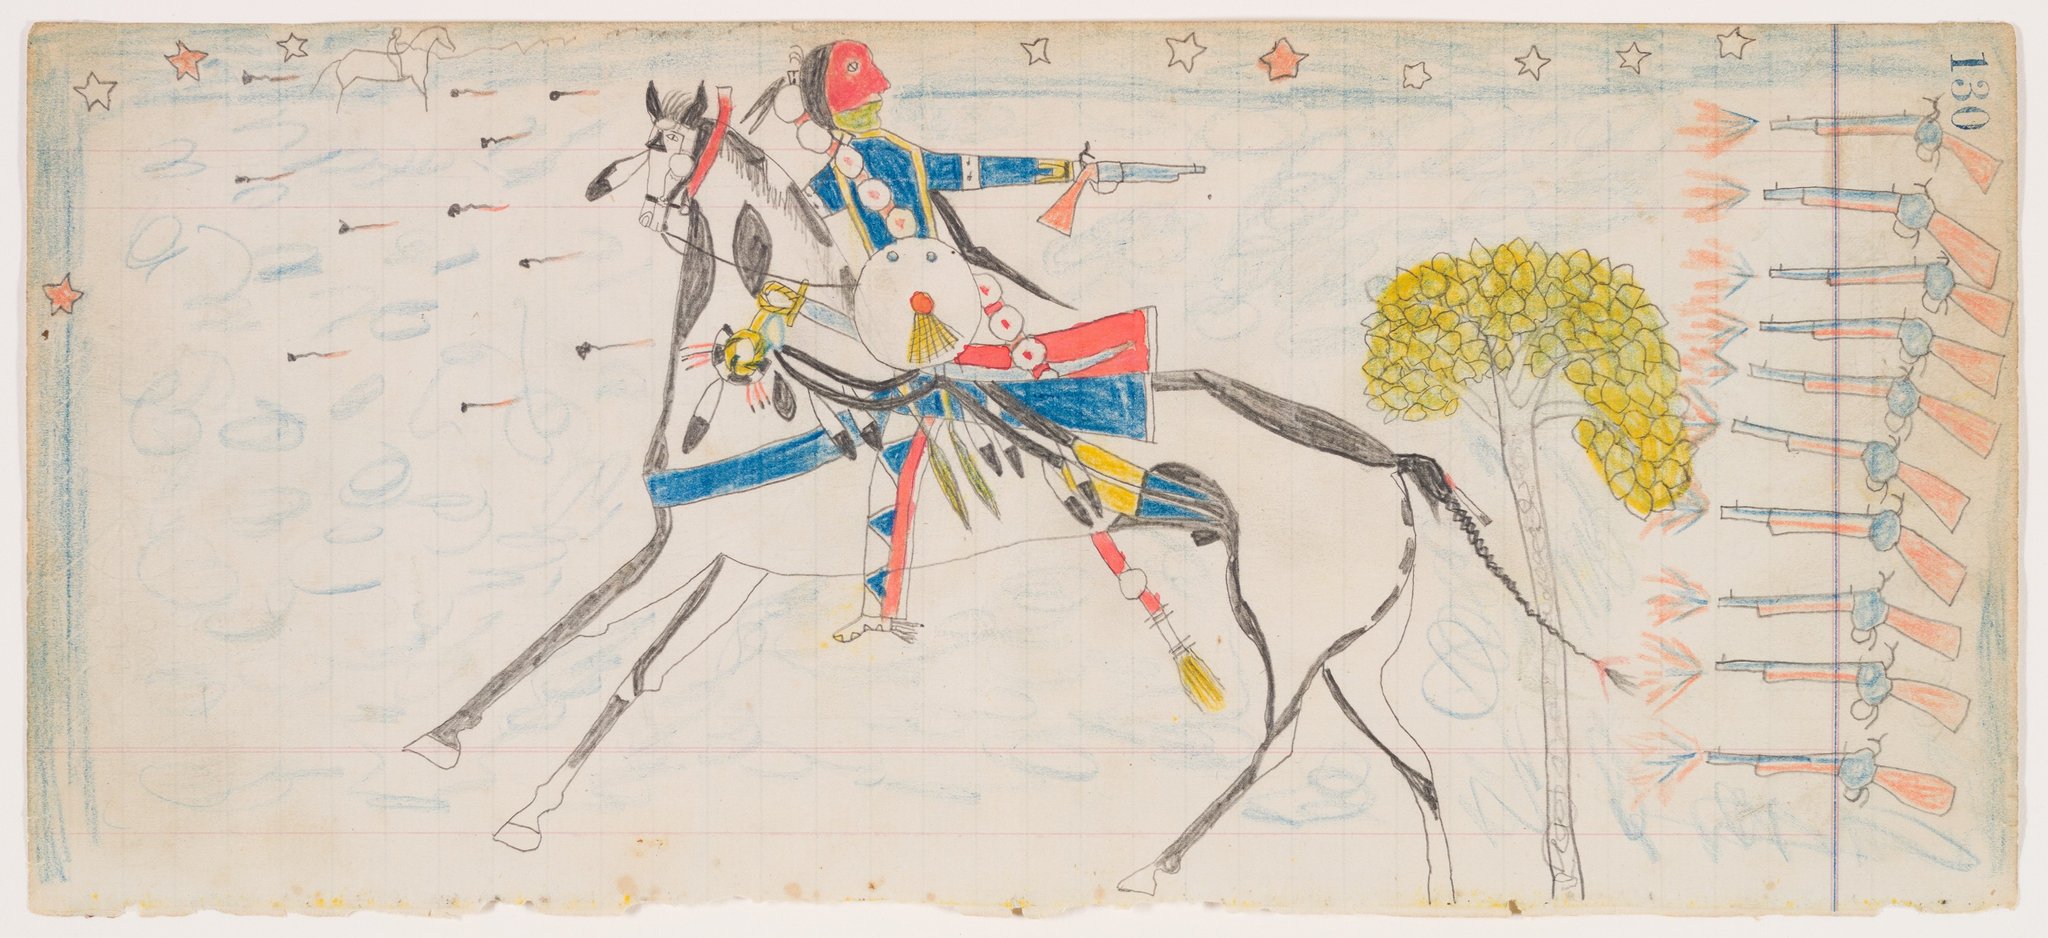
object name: drawing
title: Night Skirmish (Henderson Ledger Artist A)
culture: arapaho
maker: frank henderson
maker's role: artist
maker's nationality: native american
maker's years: 1862-1885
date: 1882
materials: paper, pencil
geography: united states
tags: firearms,horses,trees